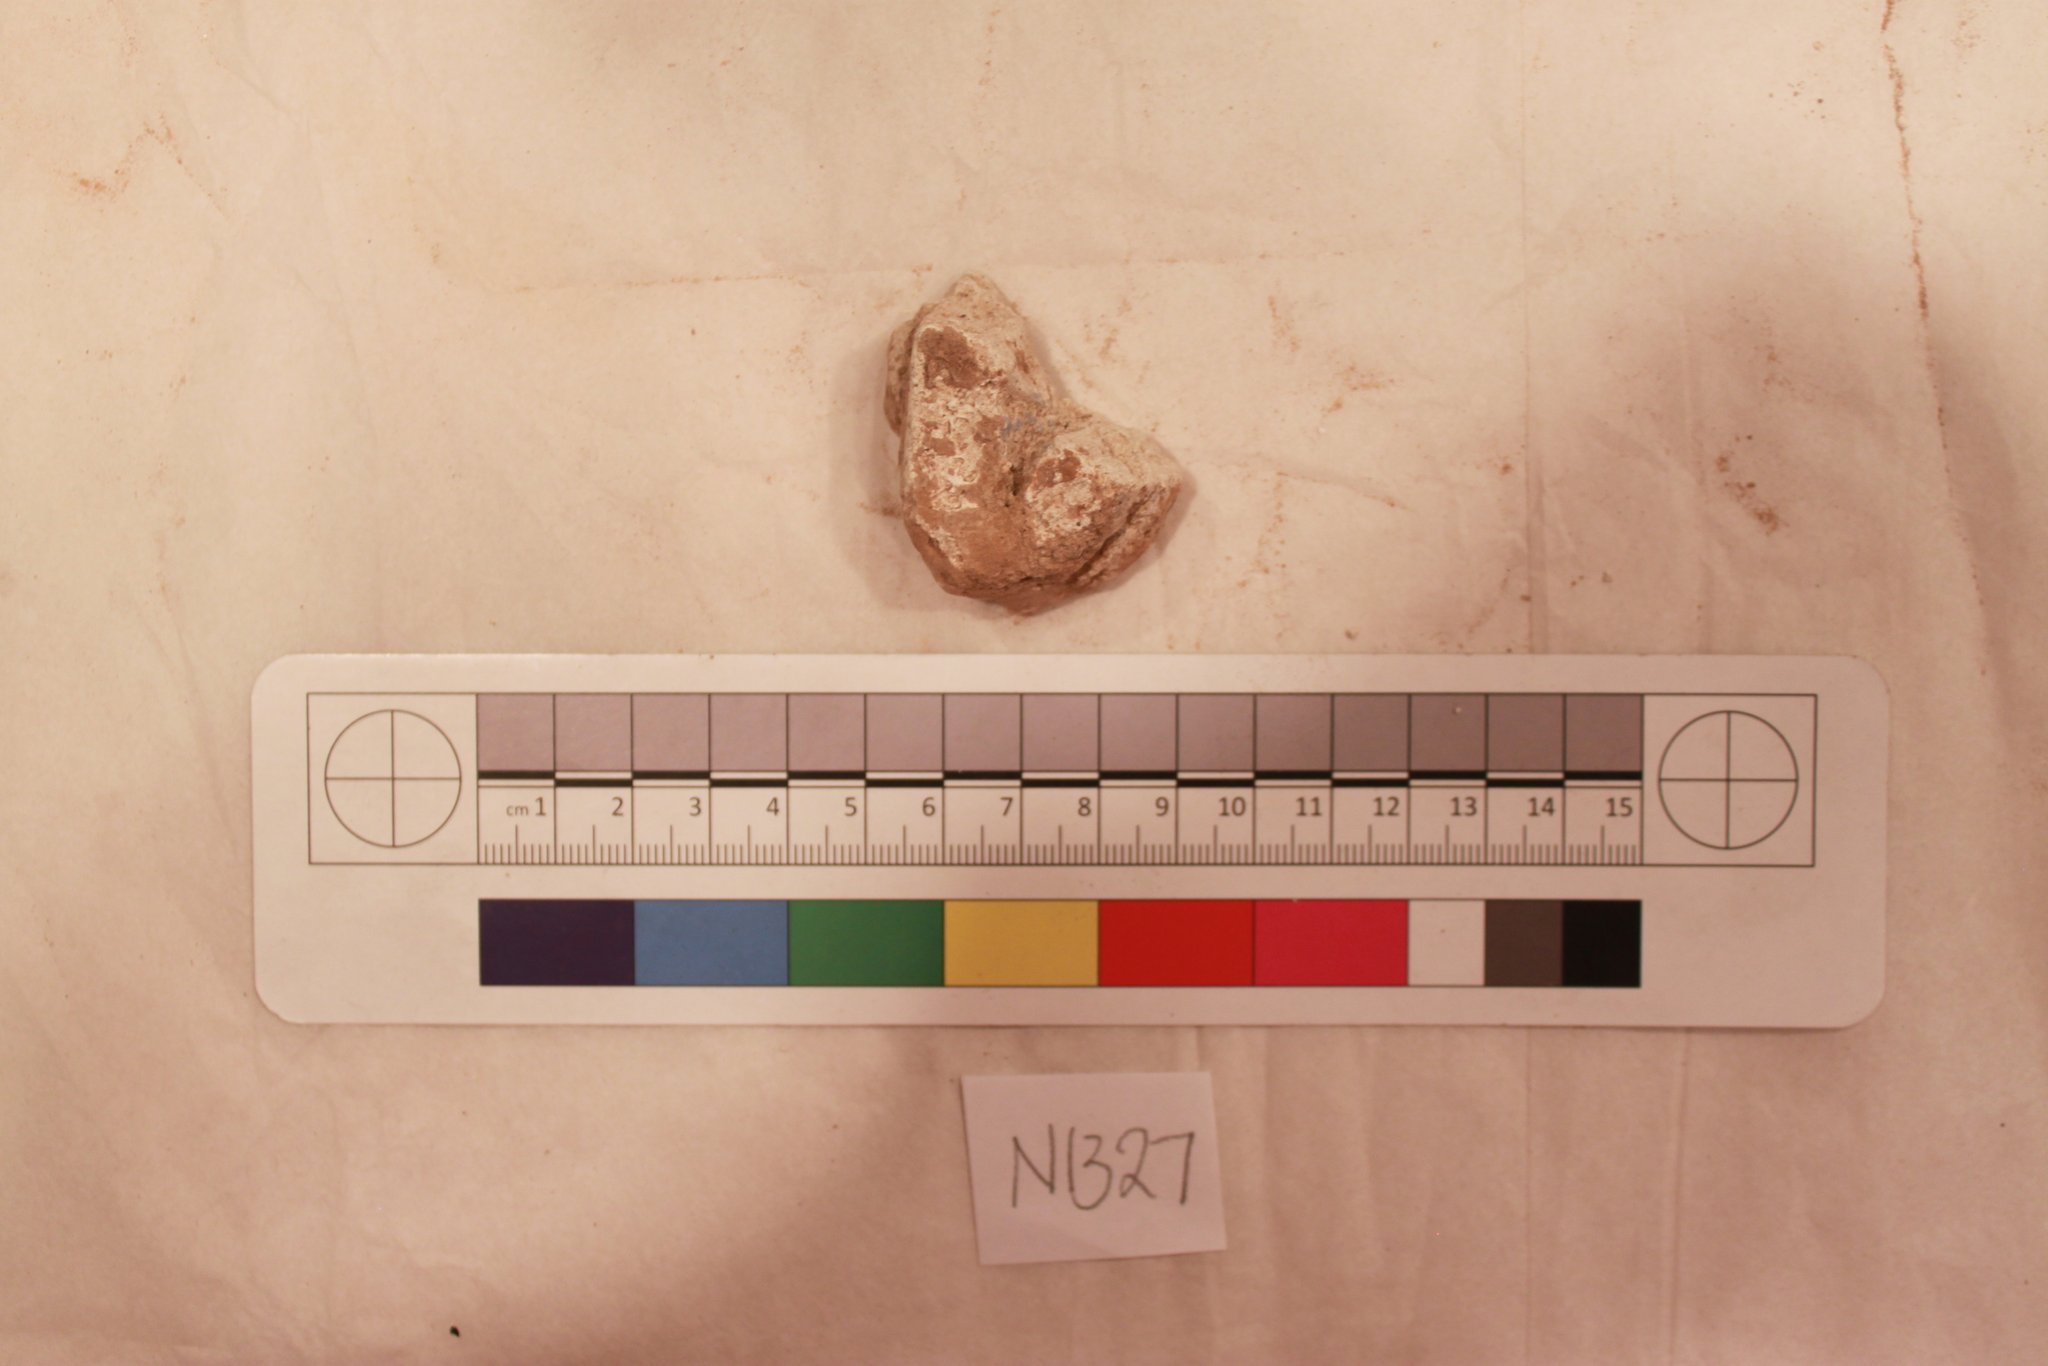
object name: fragment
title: Stucco Fragment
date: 701-1200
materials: plaster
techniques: carving, painting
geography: iran